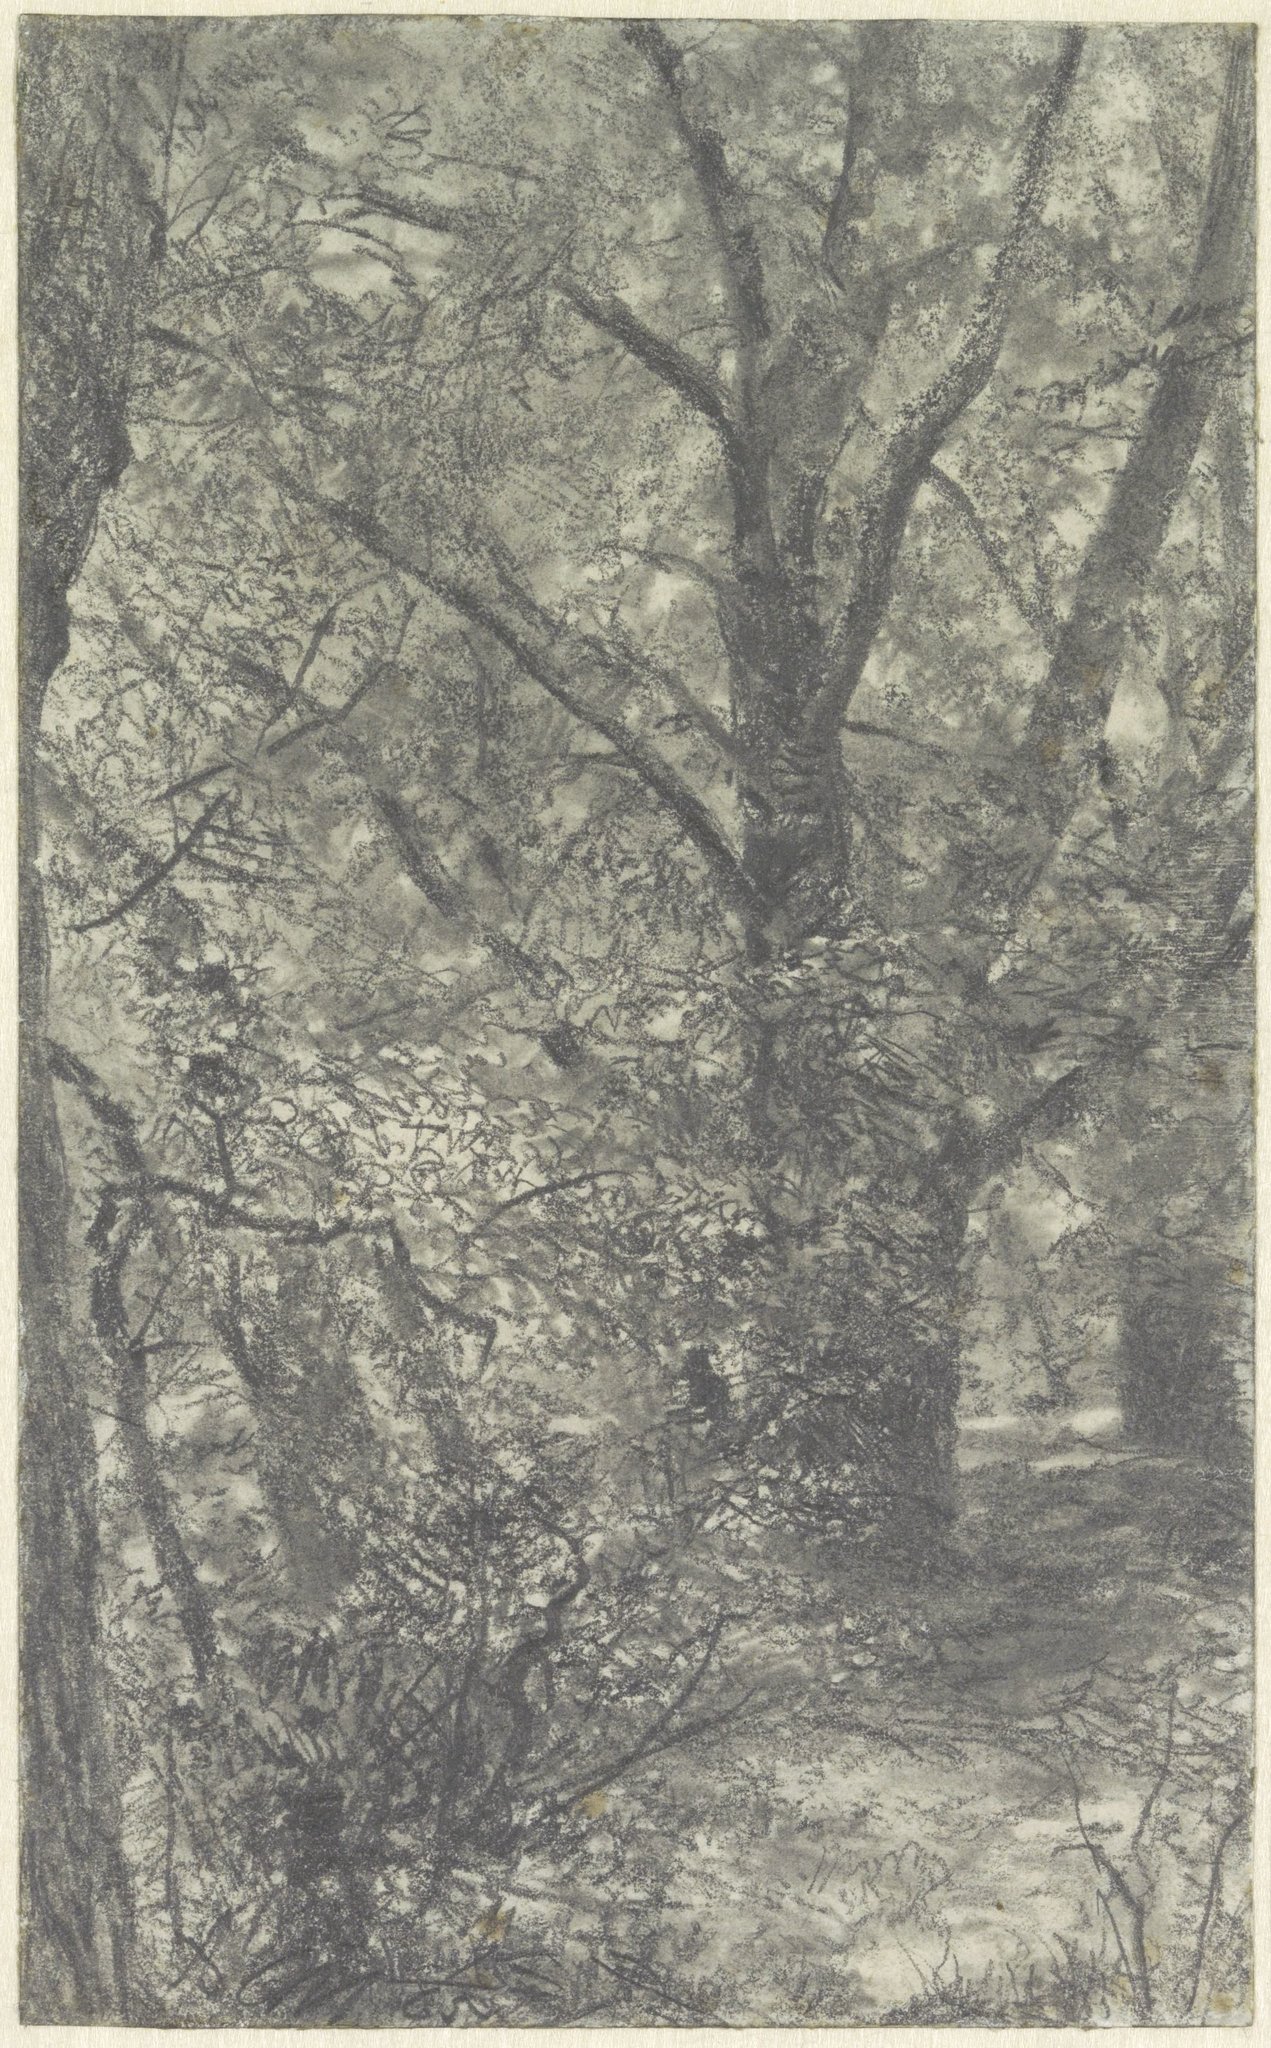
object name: drawing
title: Gezicht in het bos, op een bospad, langs een wijdvertakte oude boom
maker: adolph menzel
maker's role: draughtsman, painter, print maker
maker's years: 1815-1905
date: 1865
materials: chalk, paper, pencil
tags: forest, wood